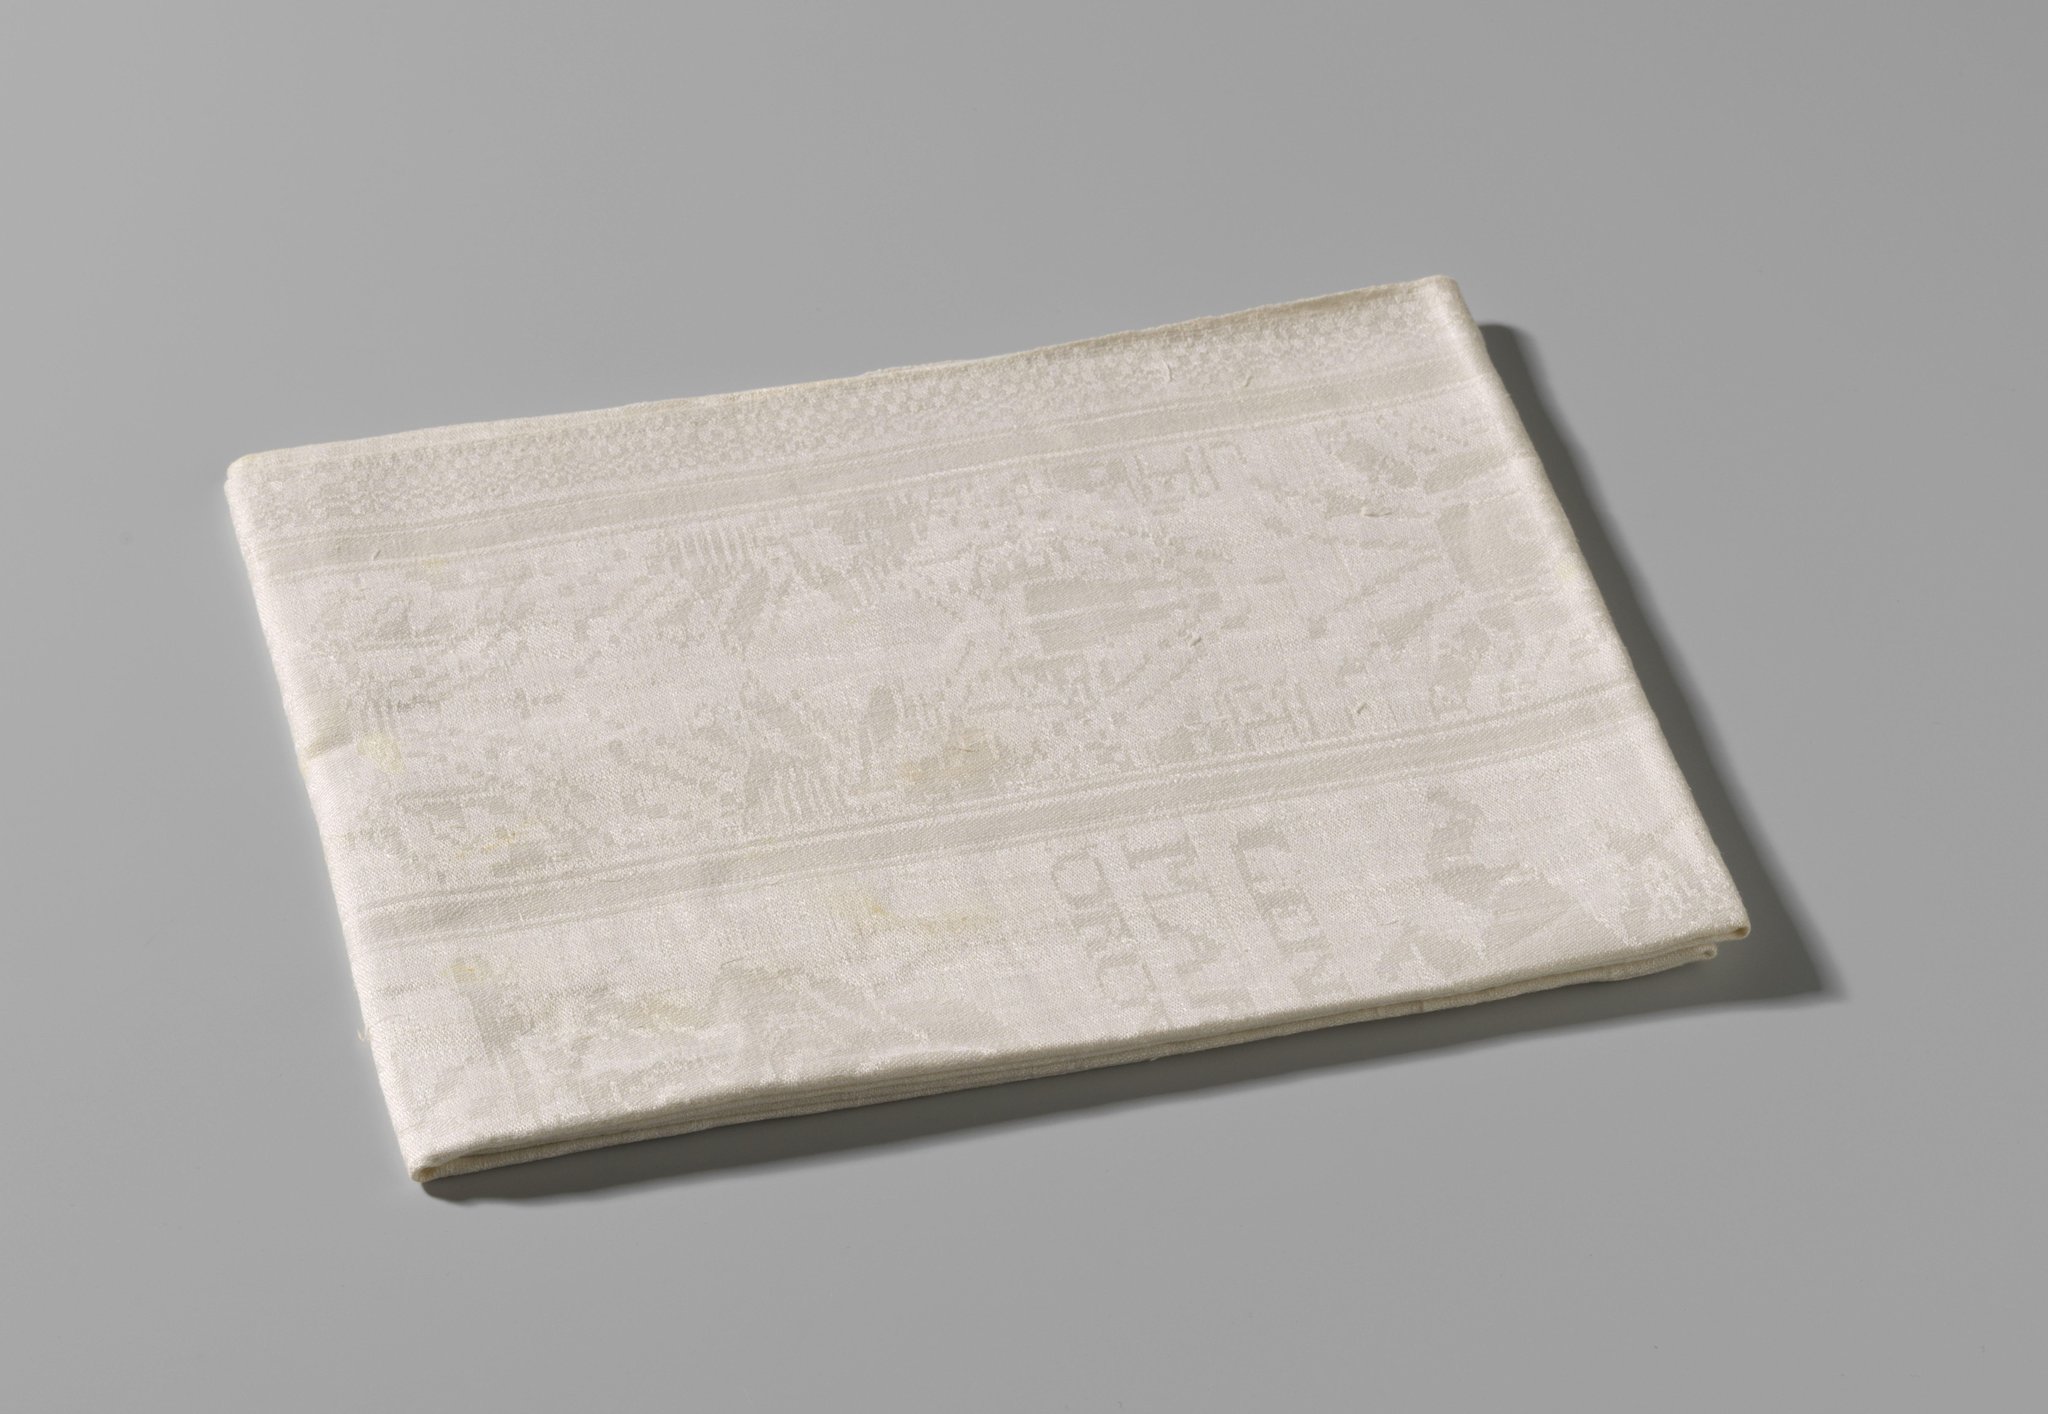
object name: napkin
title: Servet met de slag bij Malplaquet en het ruiterportret en wapen van John Churchill hertog van Marlborough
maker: Anonymous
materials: linen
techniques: damask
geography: kortrijk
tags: paris, vienna, eugenius van savoye, john churchill (1e hertog van marlborough)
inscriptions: mark: ‘12’, mark: ‘AEK’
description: Servet van linnendamast met de slag bij Malplaquet en het ruiterportret en wapen van John Churchill hertog van Marlborough. Ingeweven: GEN/ MARLB/ OROUG en MALPLAQUE.